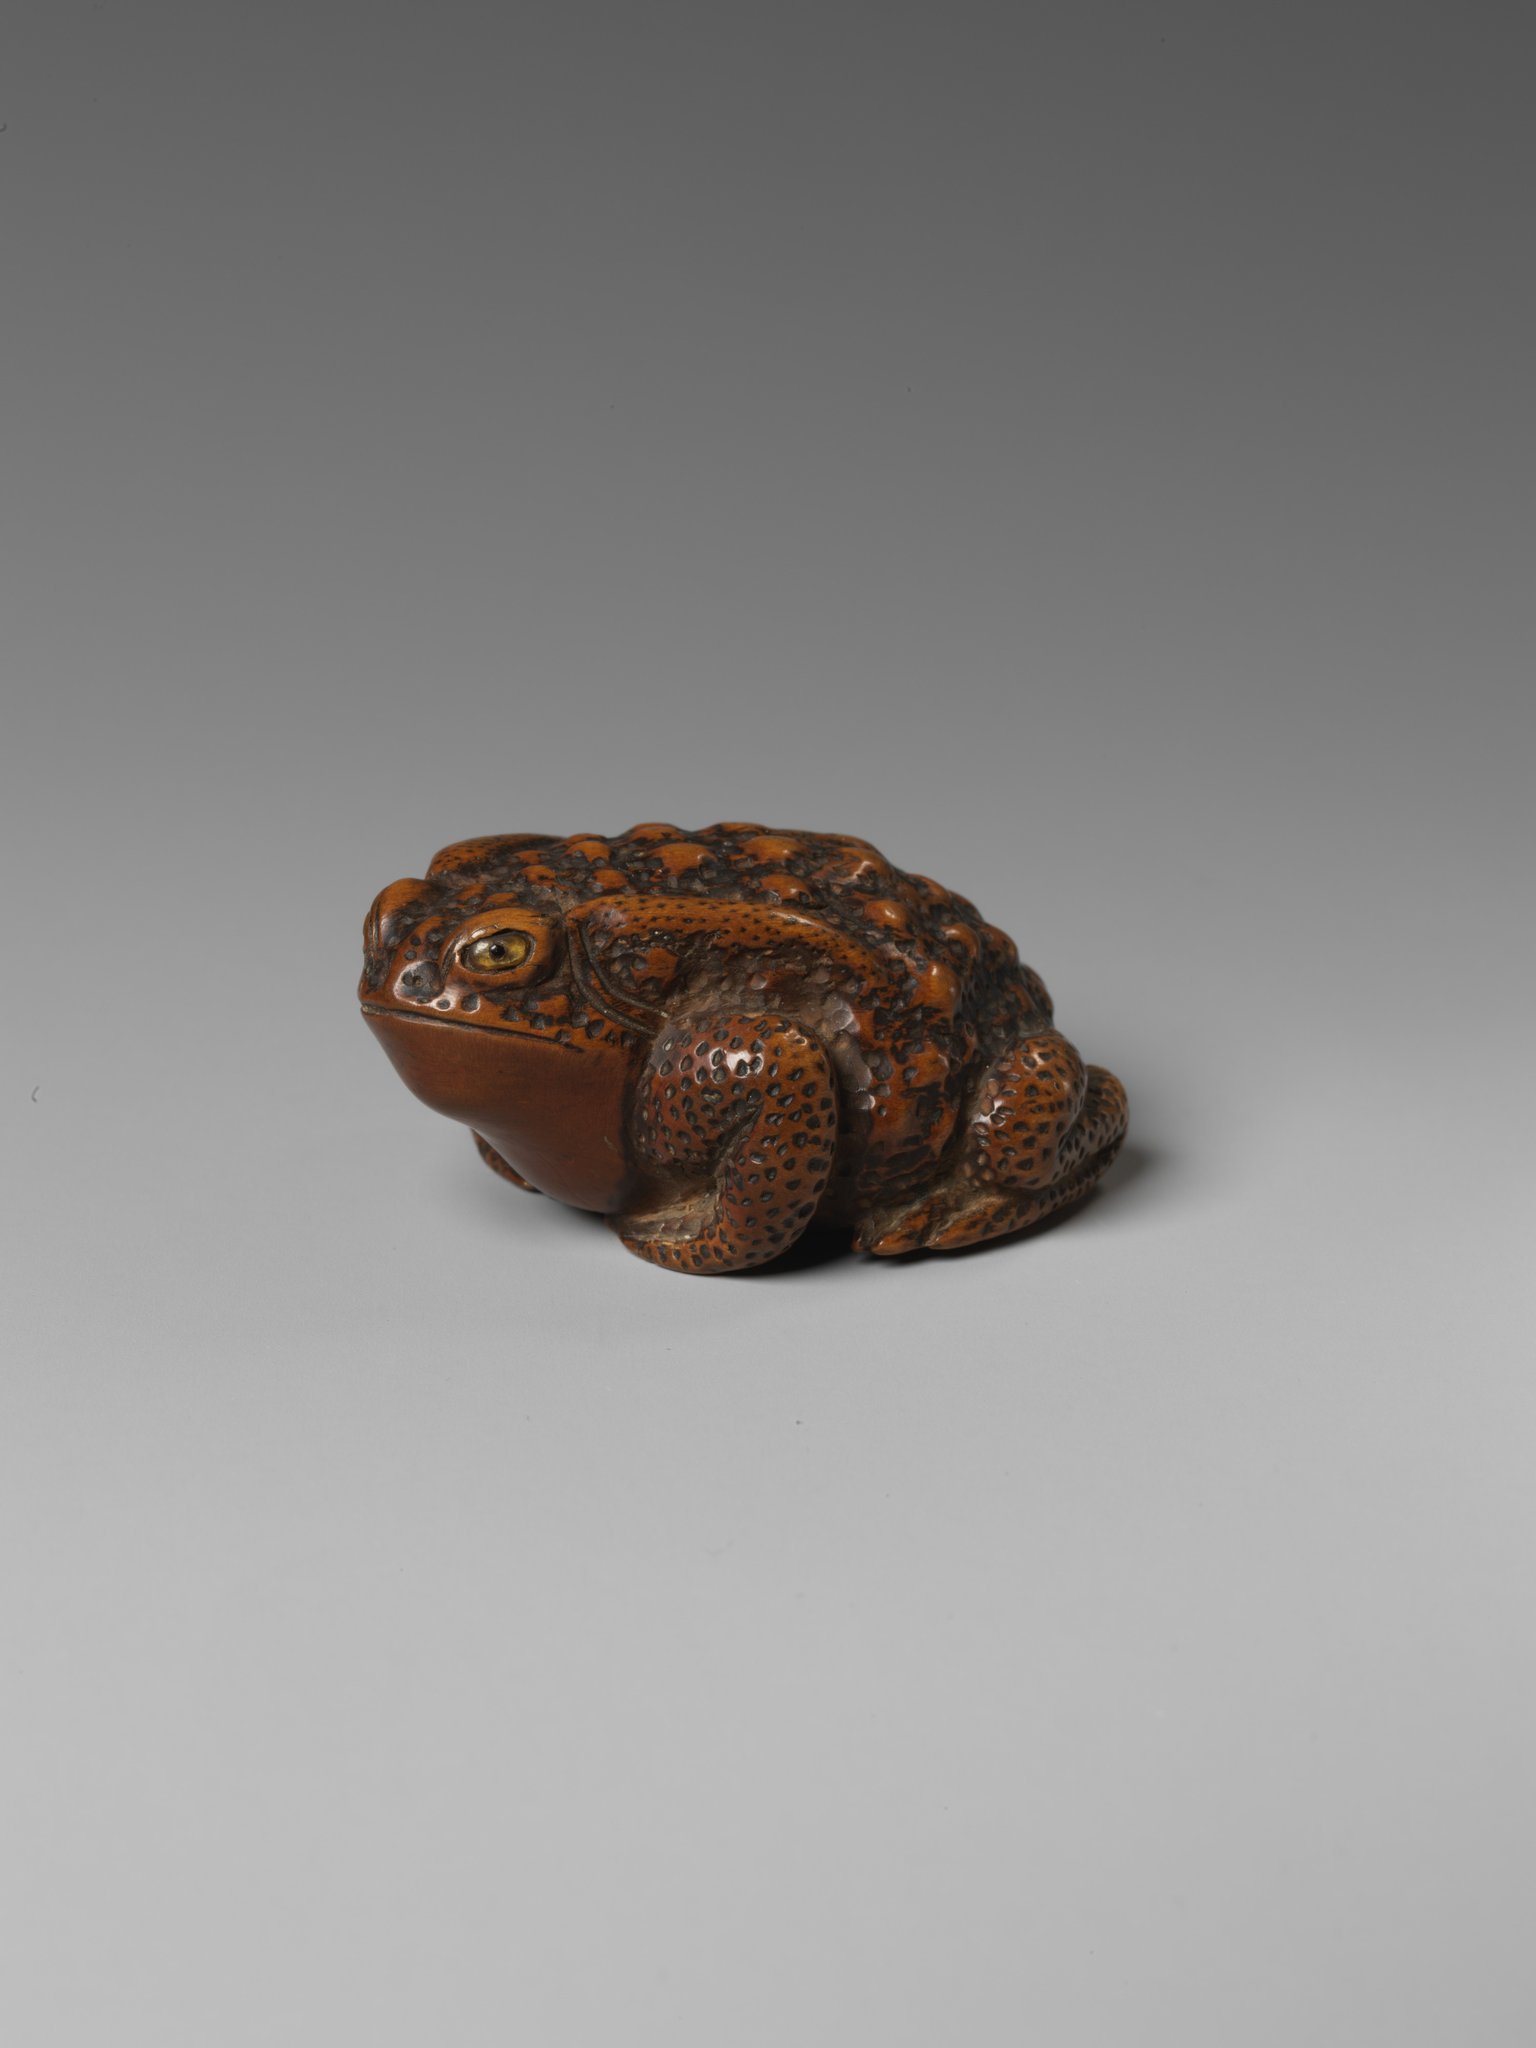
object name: netsuke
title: Frog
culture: japanese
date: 1701-1800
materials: wood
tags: frogs